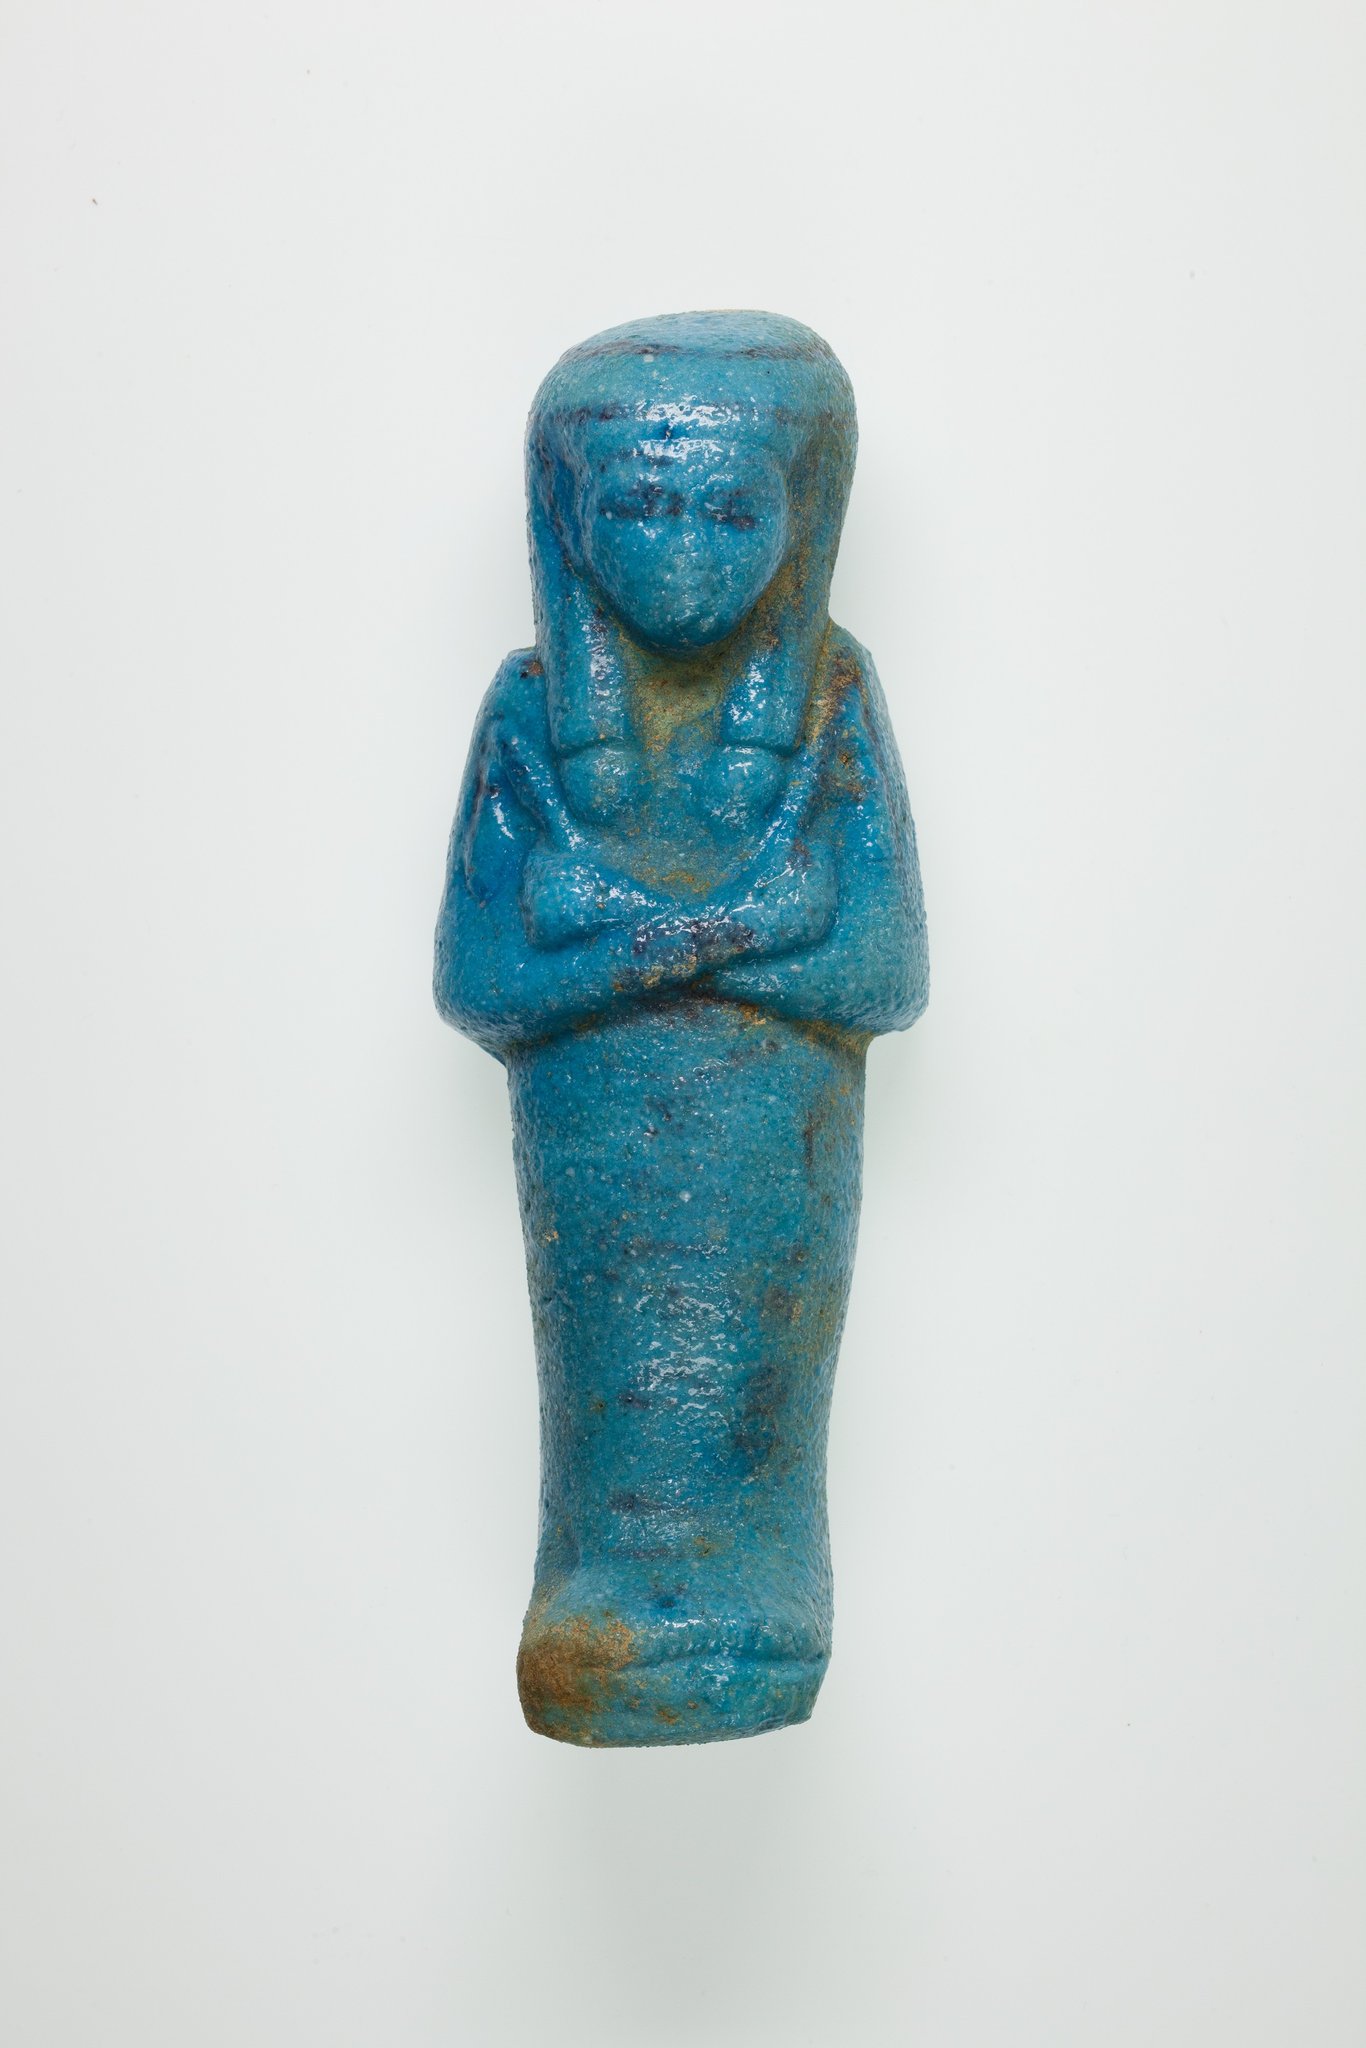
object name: shabti, henettawy c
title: Worker Shabti of Henettawy (C), Daughter of Isetemkheb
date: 990-970 BCE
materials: faience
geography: egypt